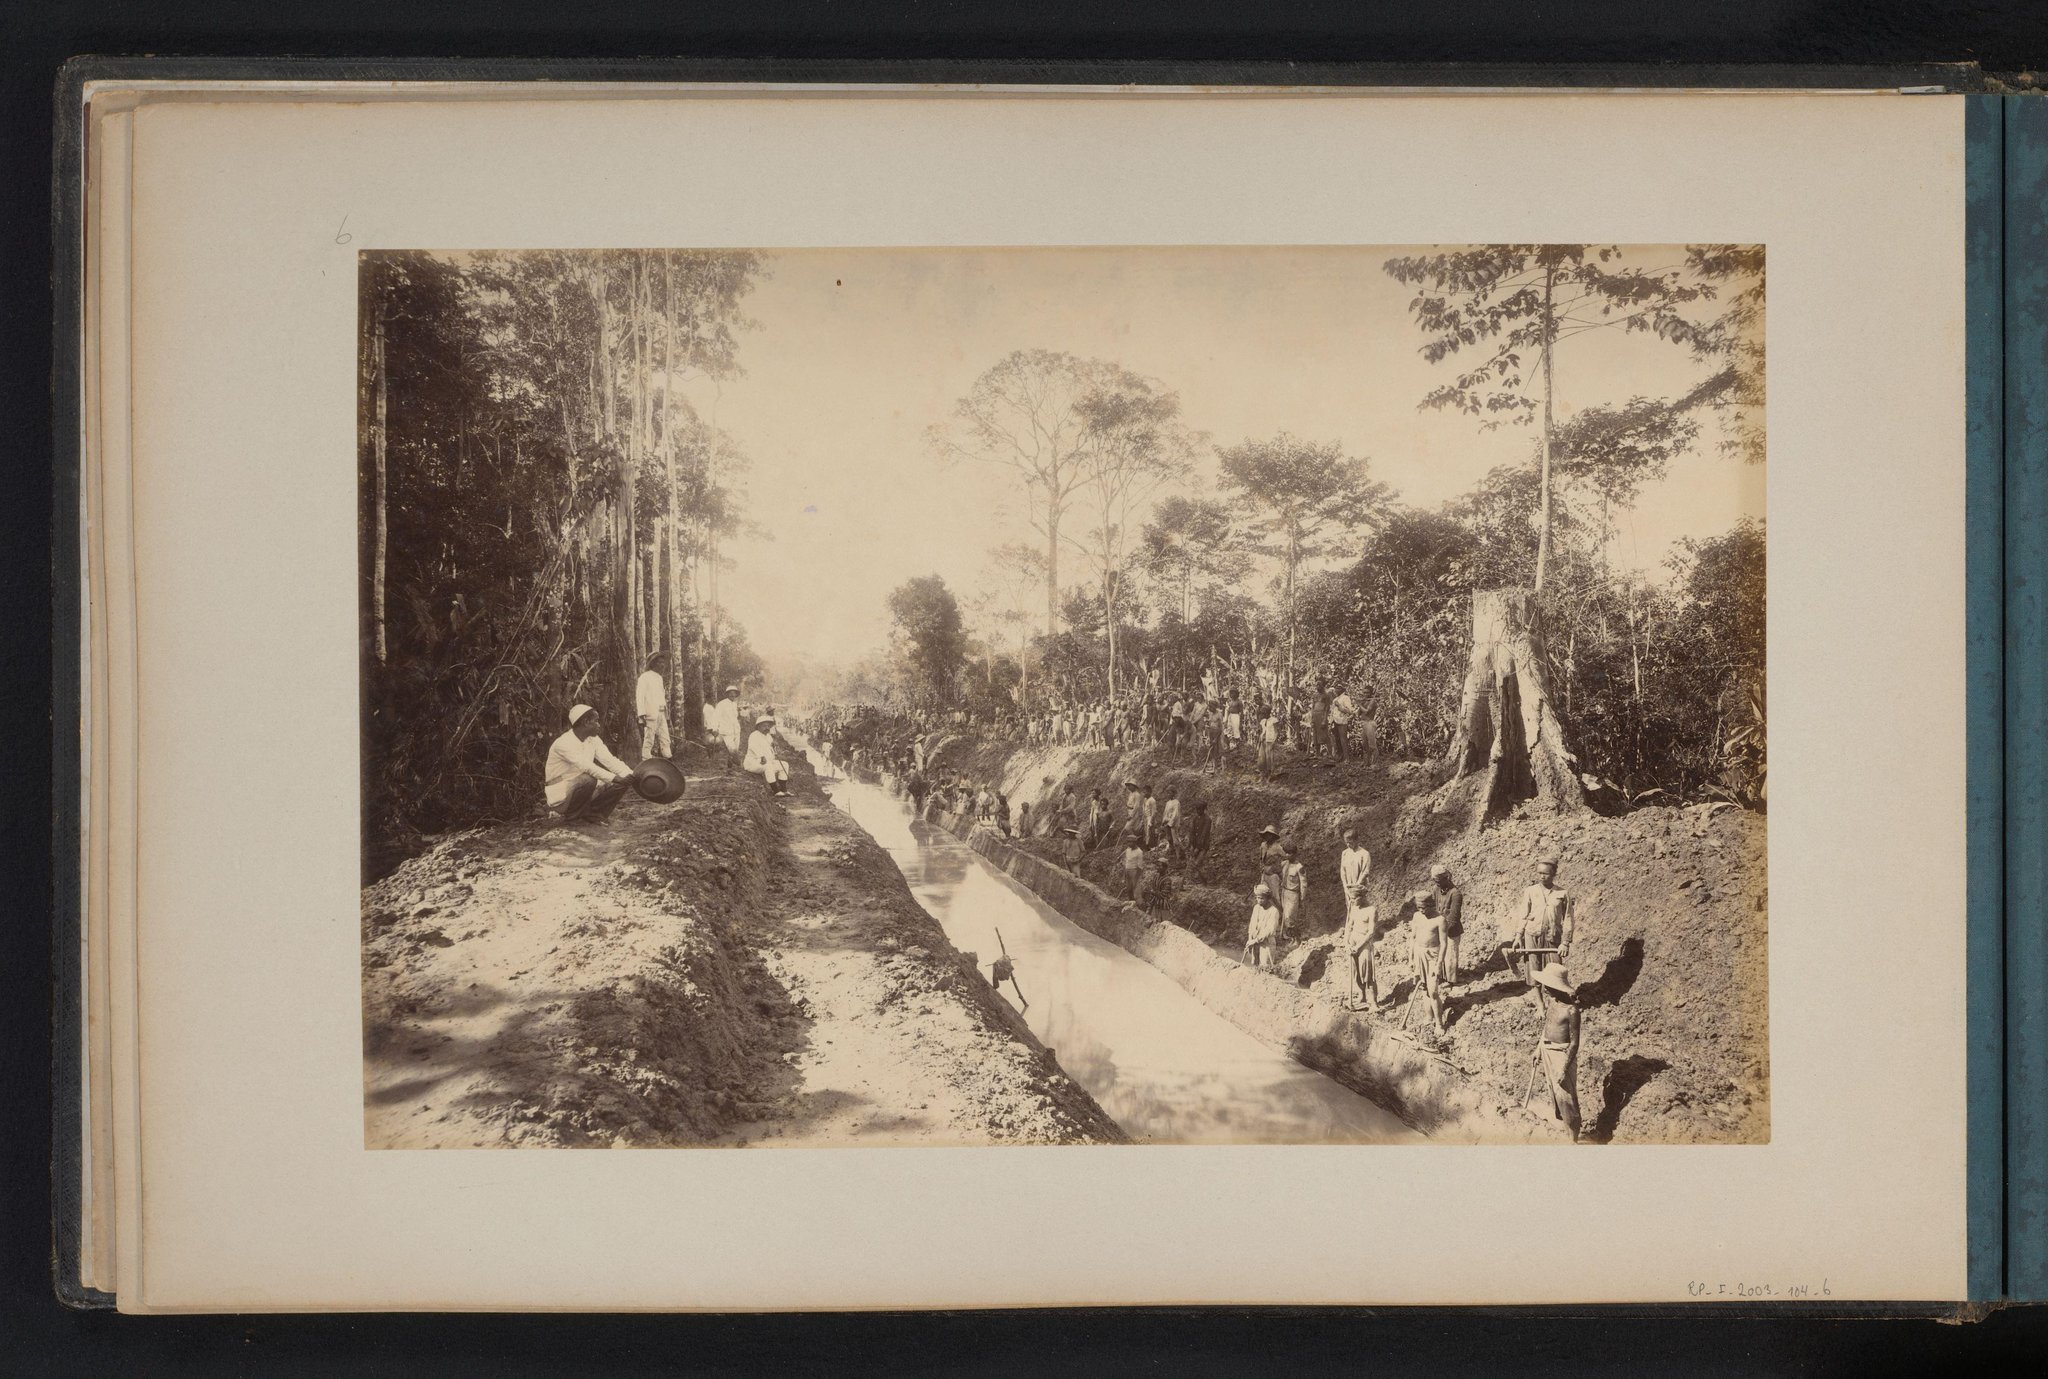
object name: photograph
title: Werkzaamheden aan de drainage op de Stabat plantage, Sumatra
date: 1890-1900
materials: cardboard, photographic support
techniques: albumen print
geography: sumatra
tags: plantation, irrigation ~ cultivation, working class, labourers, sumatra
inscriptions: number: ‘6’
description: In de lijst van afbeeldingen wordt deze foto beschreven met de woorden "Drainage Arbeiten in Stabat-Estate".